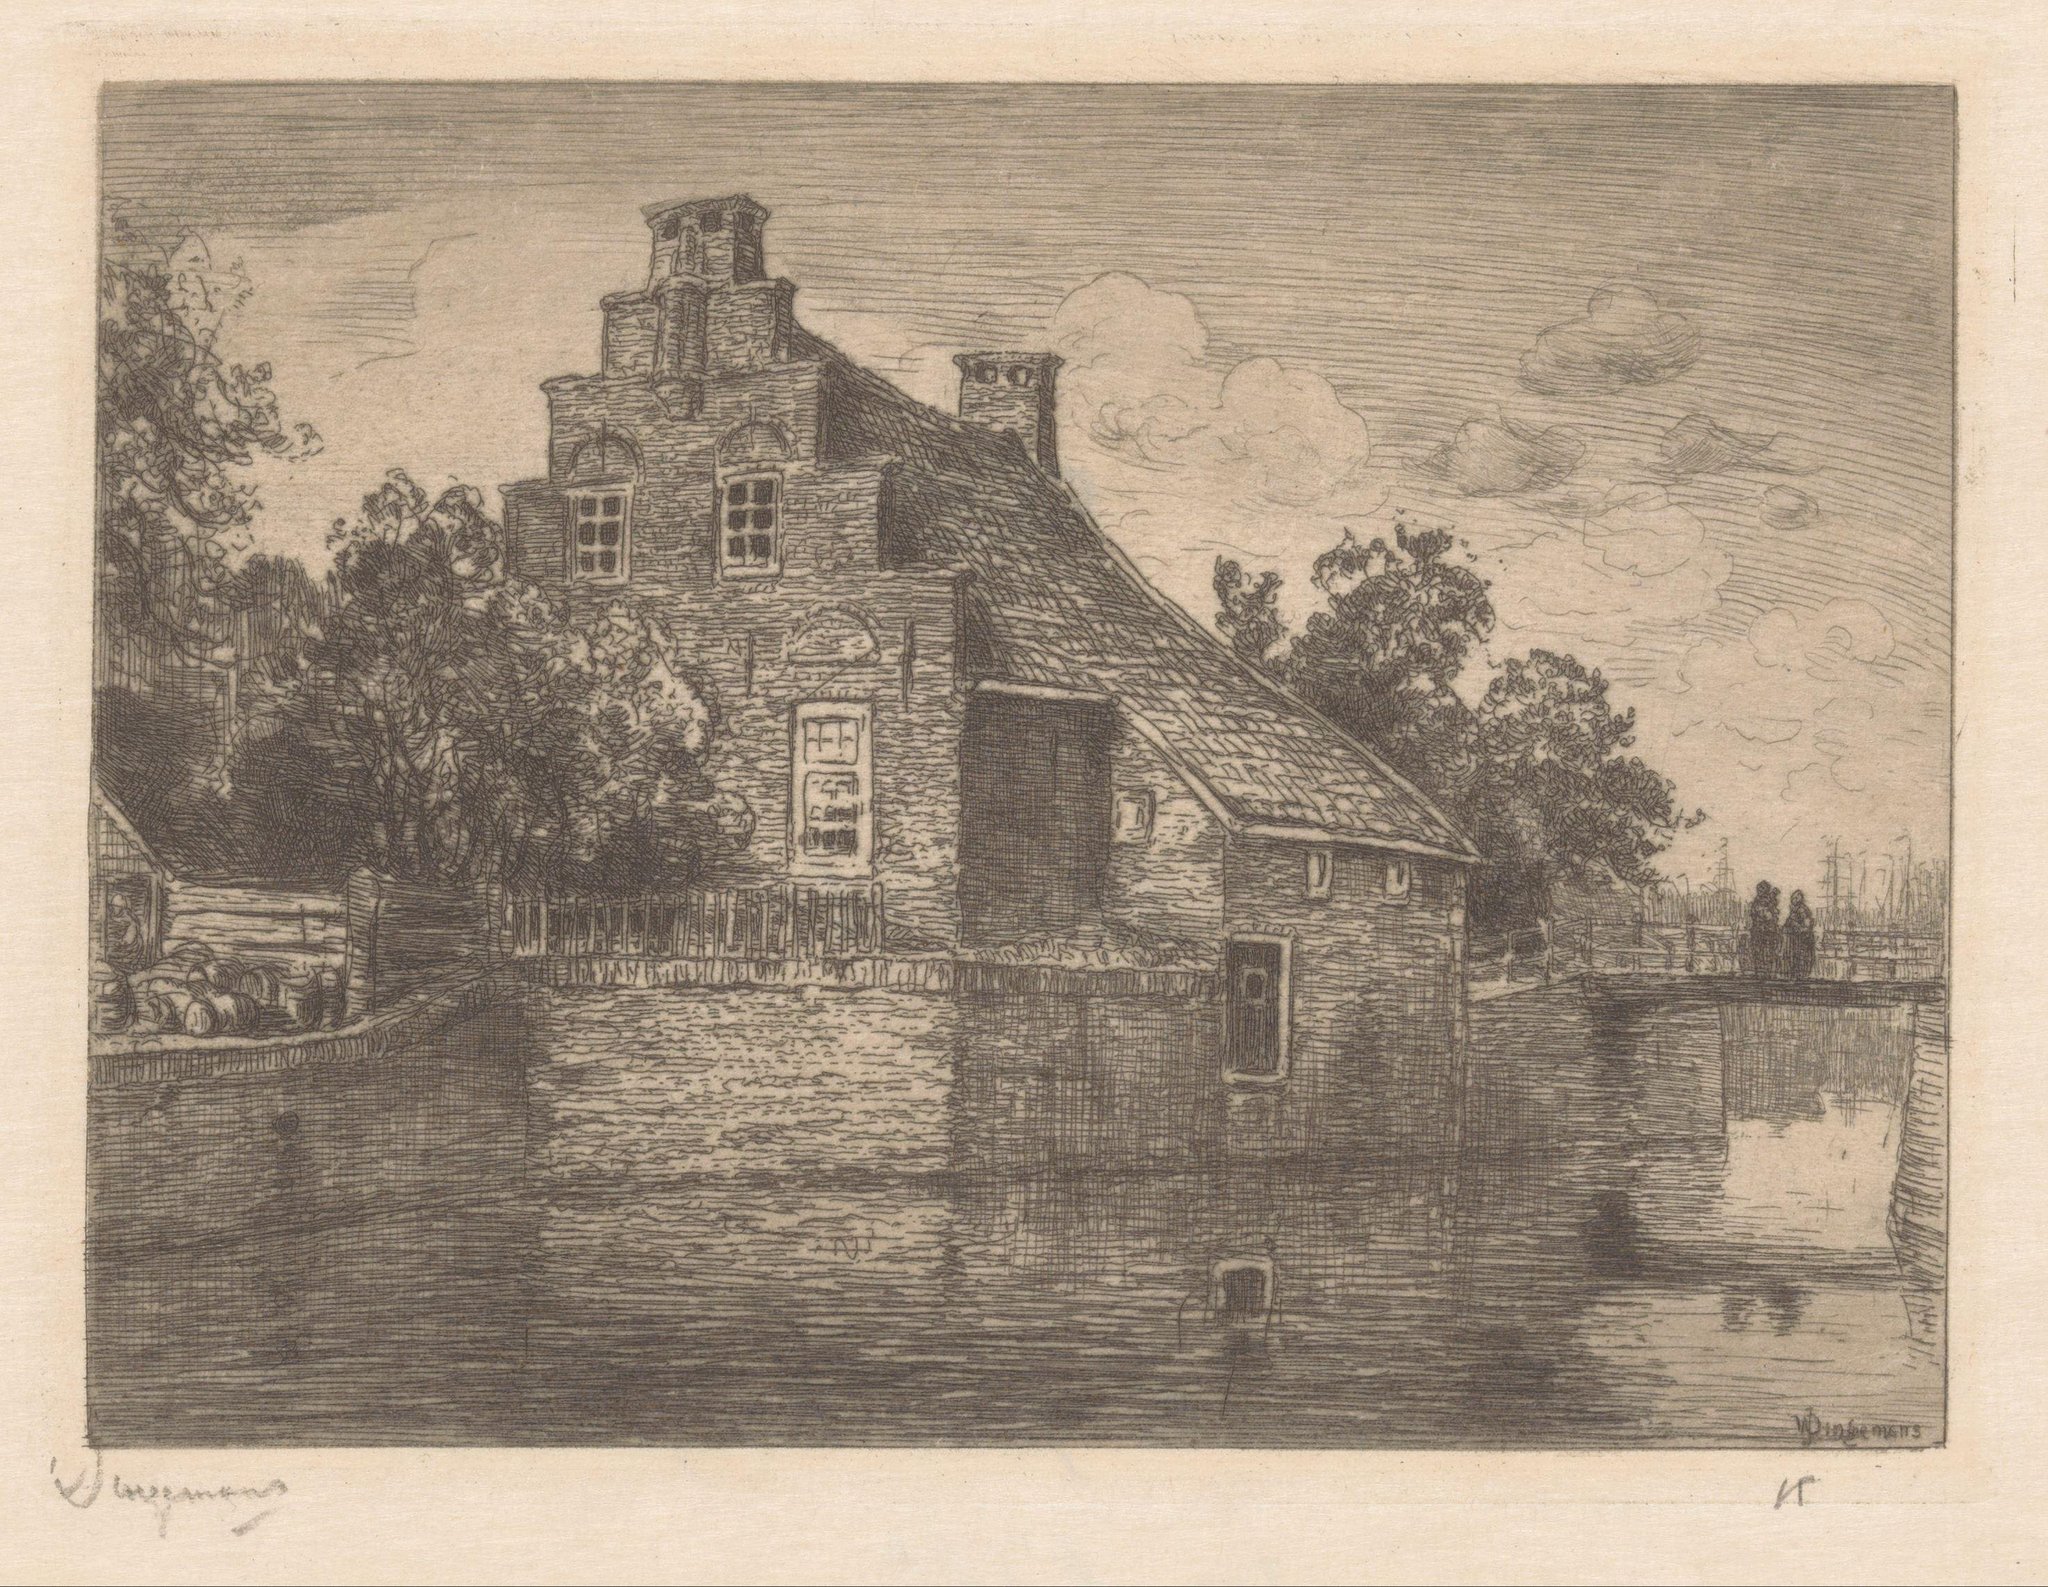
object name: print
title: Poortershuis aan het Damsterdiep in Groningen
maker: waalko jans dingemans (i)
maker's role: draughtsman, print maker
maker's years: 1873-1925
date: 1883-1925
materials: paper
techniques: etching, intaglio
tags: small canal, ditch, farm or solitary house in landscape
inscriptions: number: ‘15’, collector's mark: Lugt 2228, collector's mark: Lugt 2760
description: Rechts op de achtergrond een brug over het Damsterdiep.